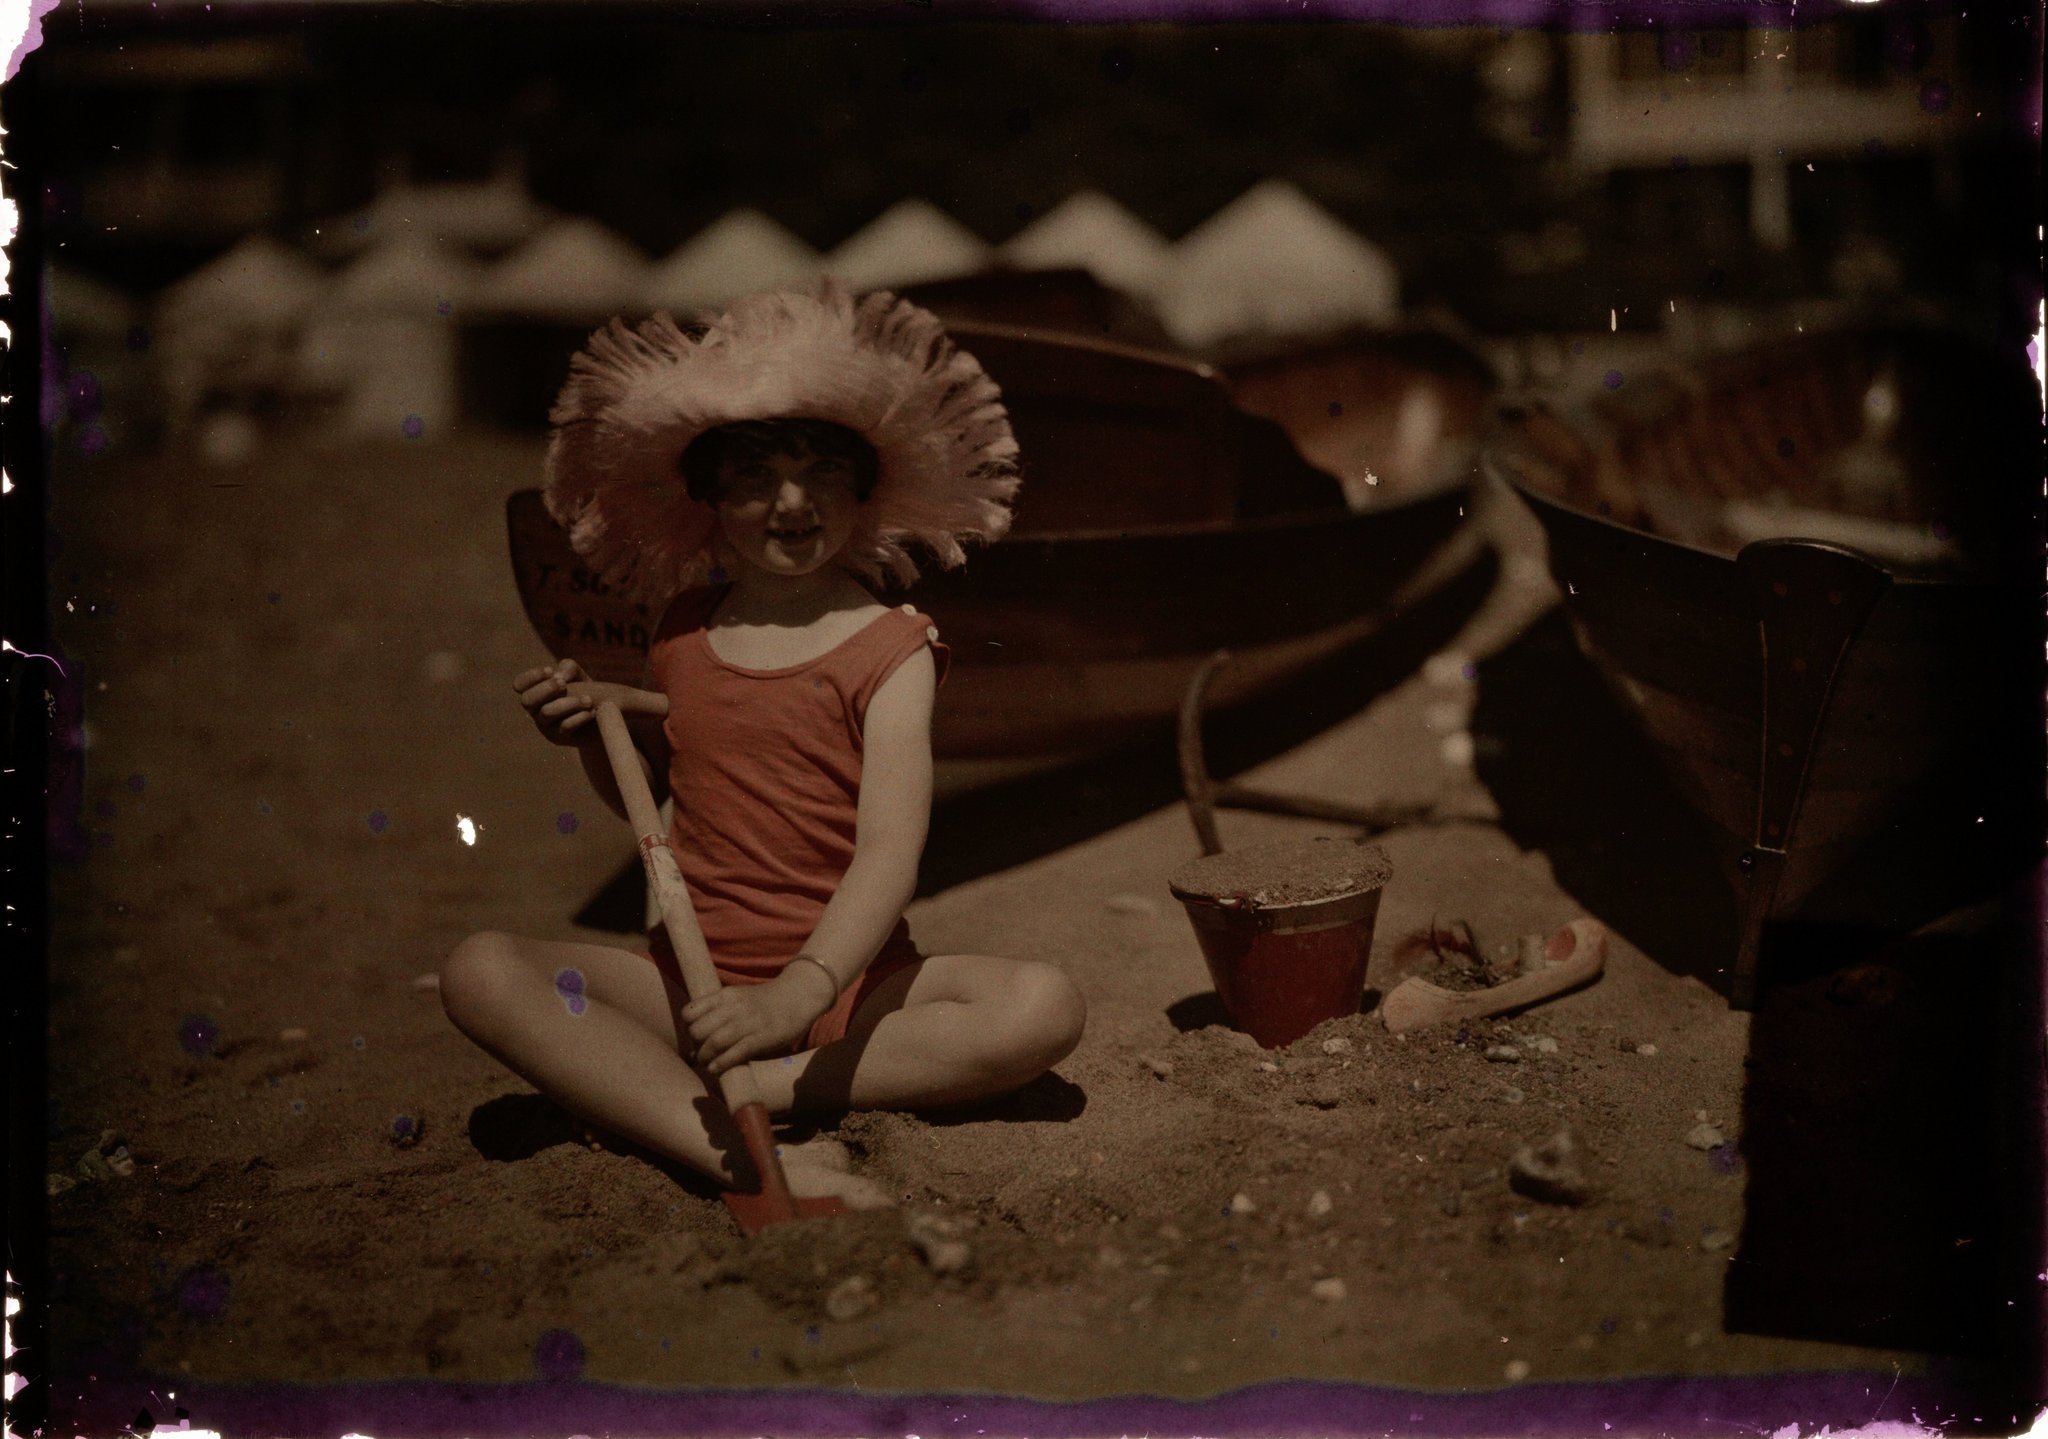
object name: photograph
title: Meisje op Engels strand, Sandown, Isle of Wight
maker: clifton r. adams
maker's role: fotograaf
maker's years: 1890-1934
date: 1920-1935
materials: glass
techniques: autochrome process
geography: isle of wight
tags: beach (as place of recreation)